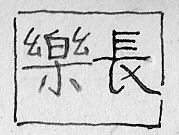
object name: seal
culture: chinese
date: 206 BCE-220 CE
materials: jade